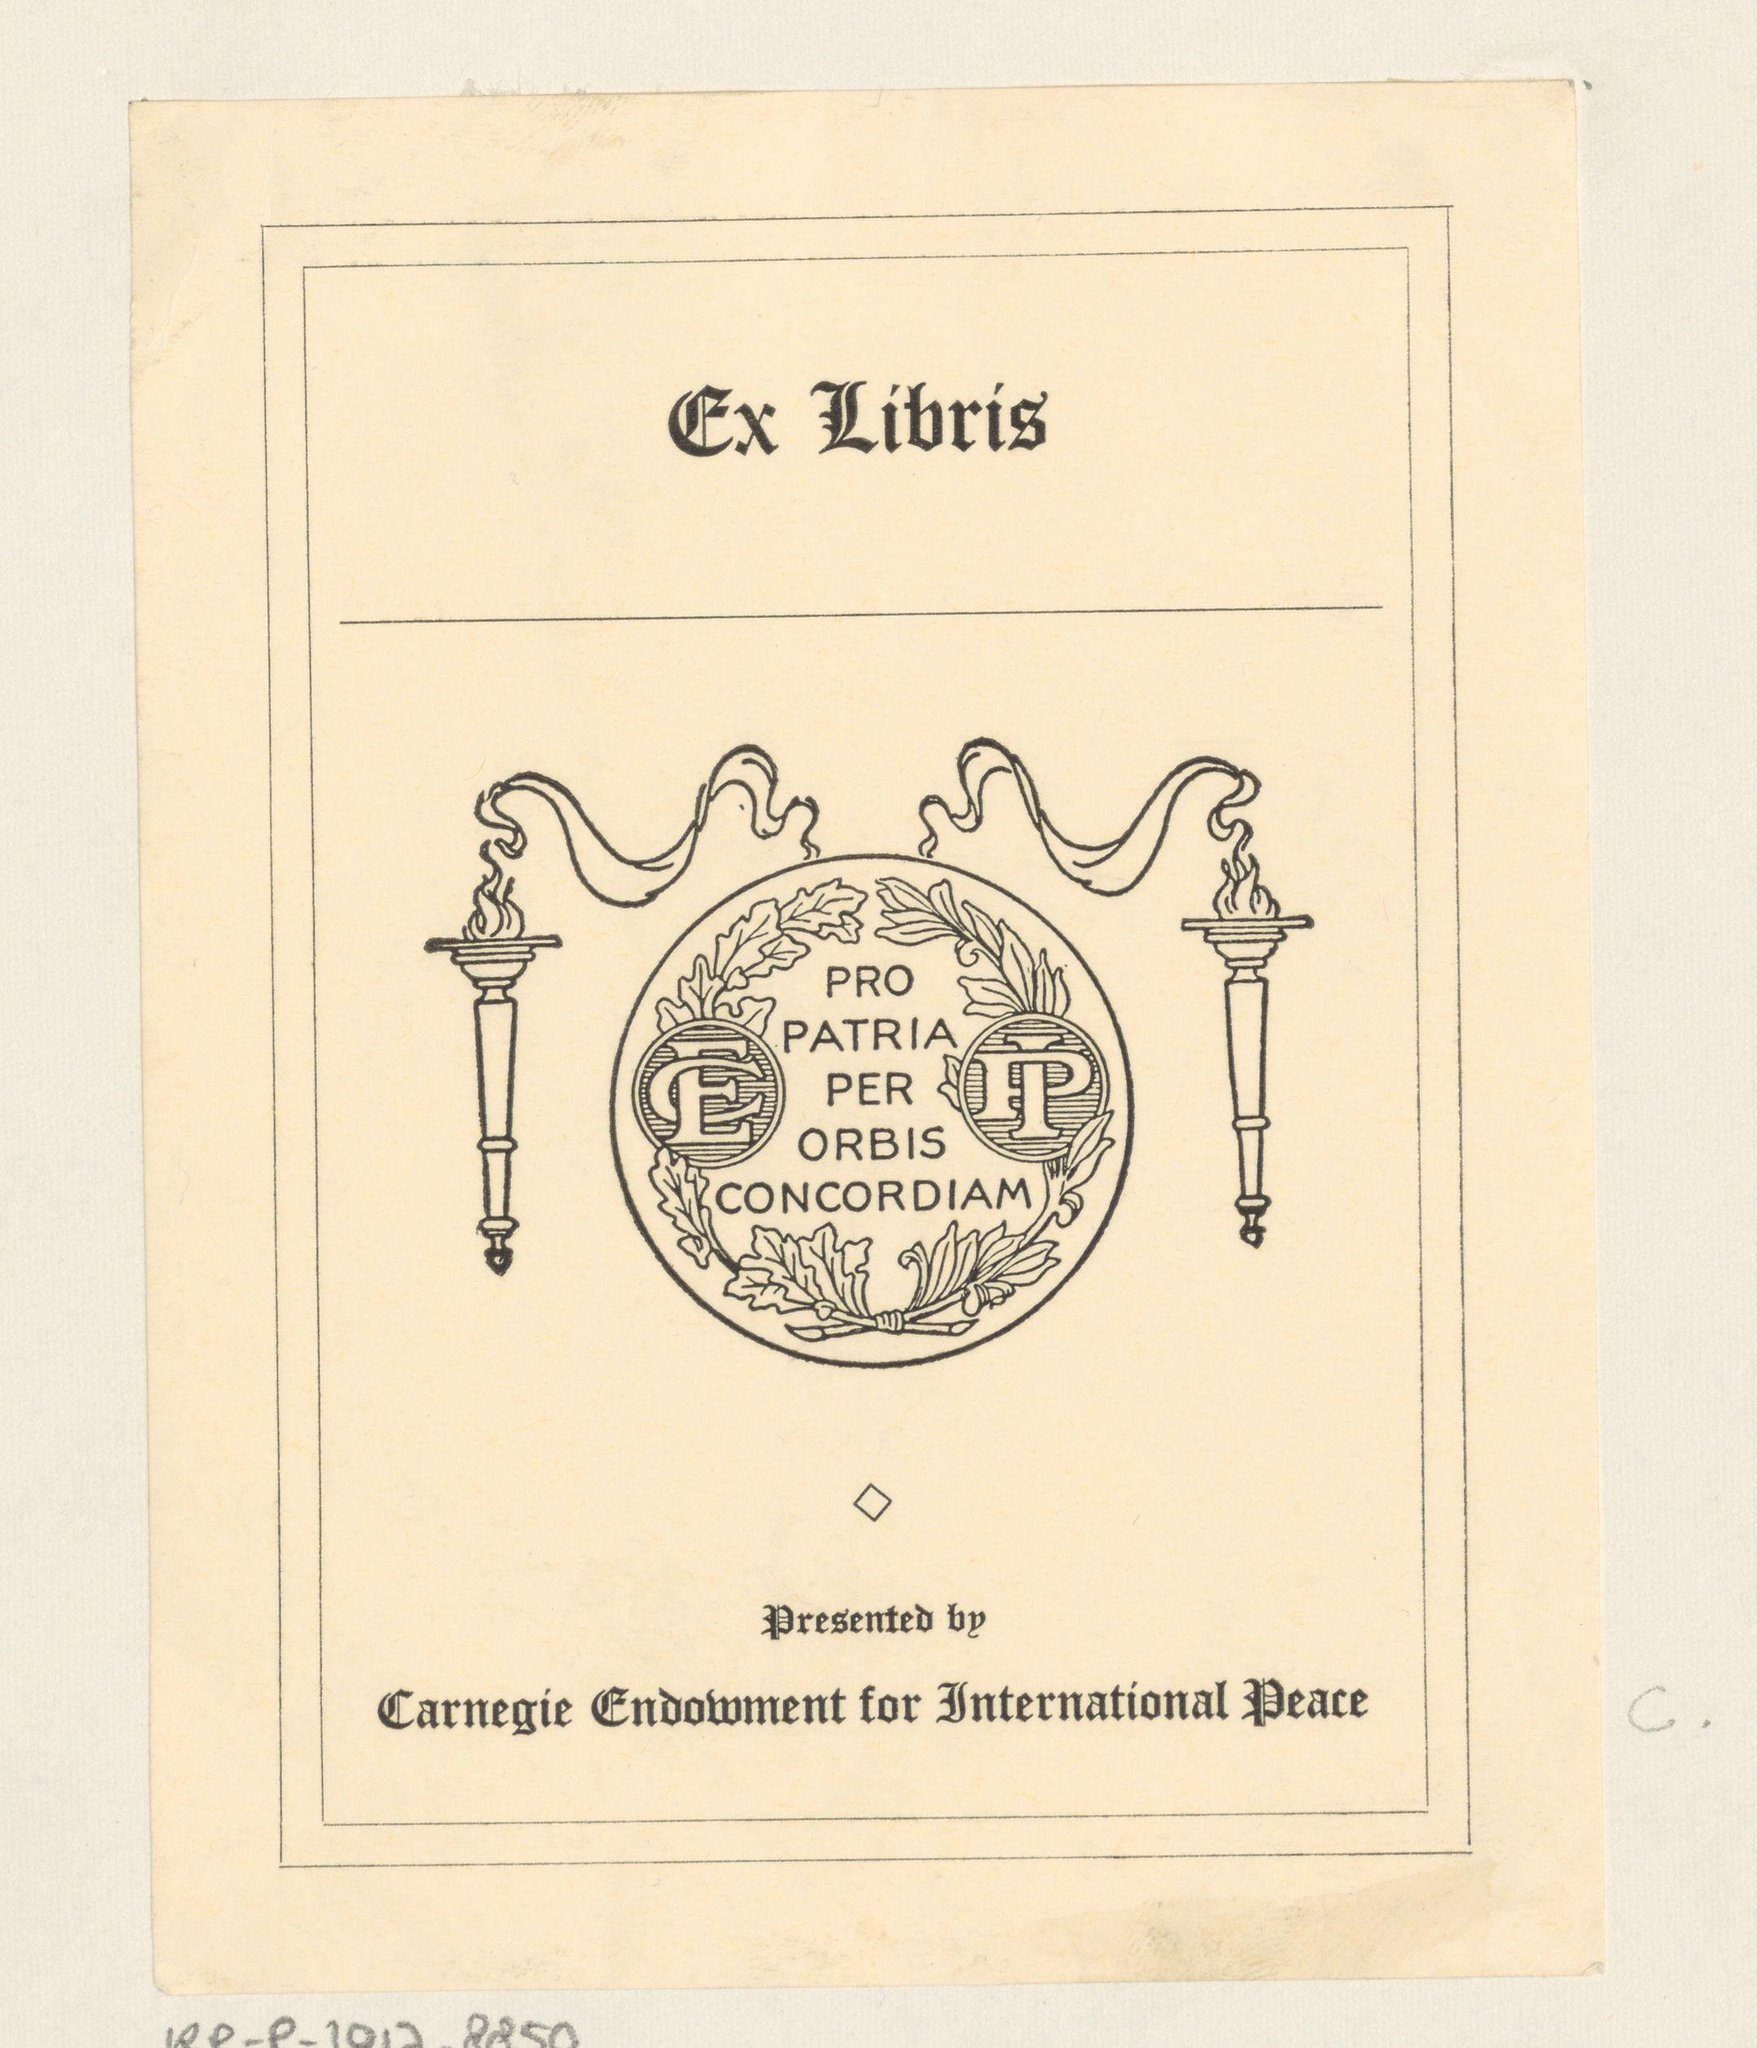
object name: bookplate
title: Ex libris van de Carnegie Endowment for International Peace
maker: Anonymous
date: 1910-1999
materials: paper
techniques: printing block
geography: north and central america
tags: torch